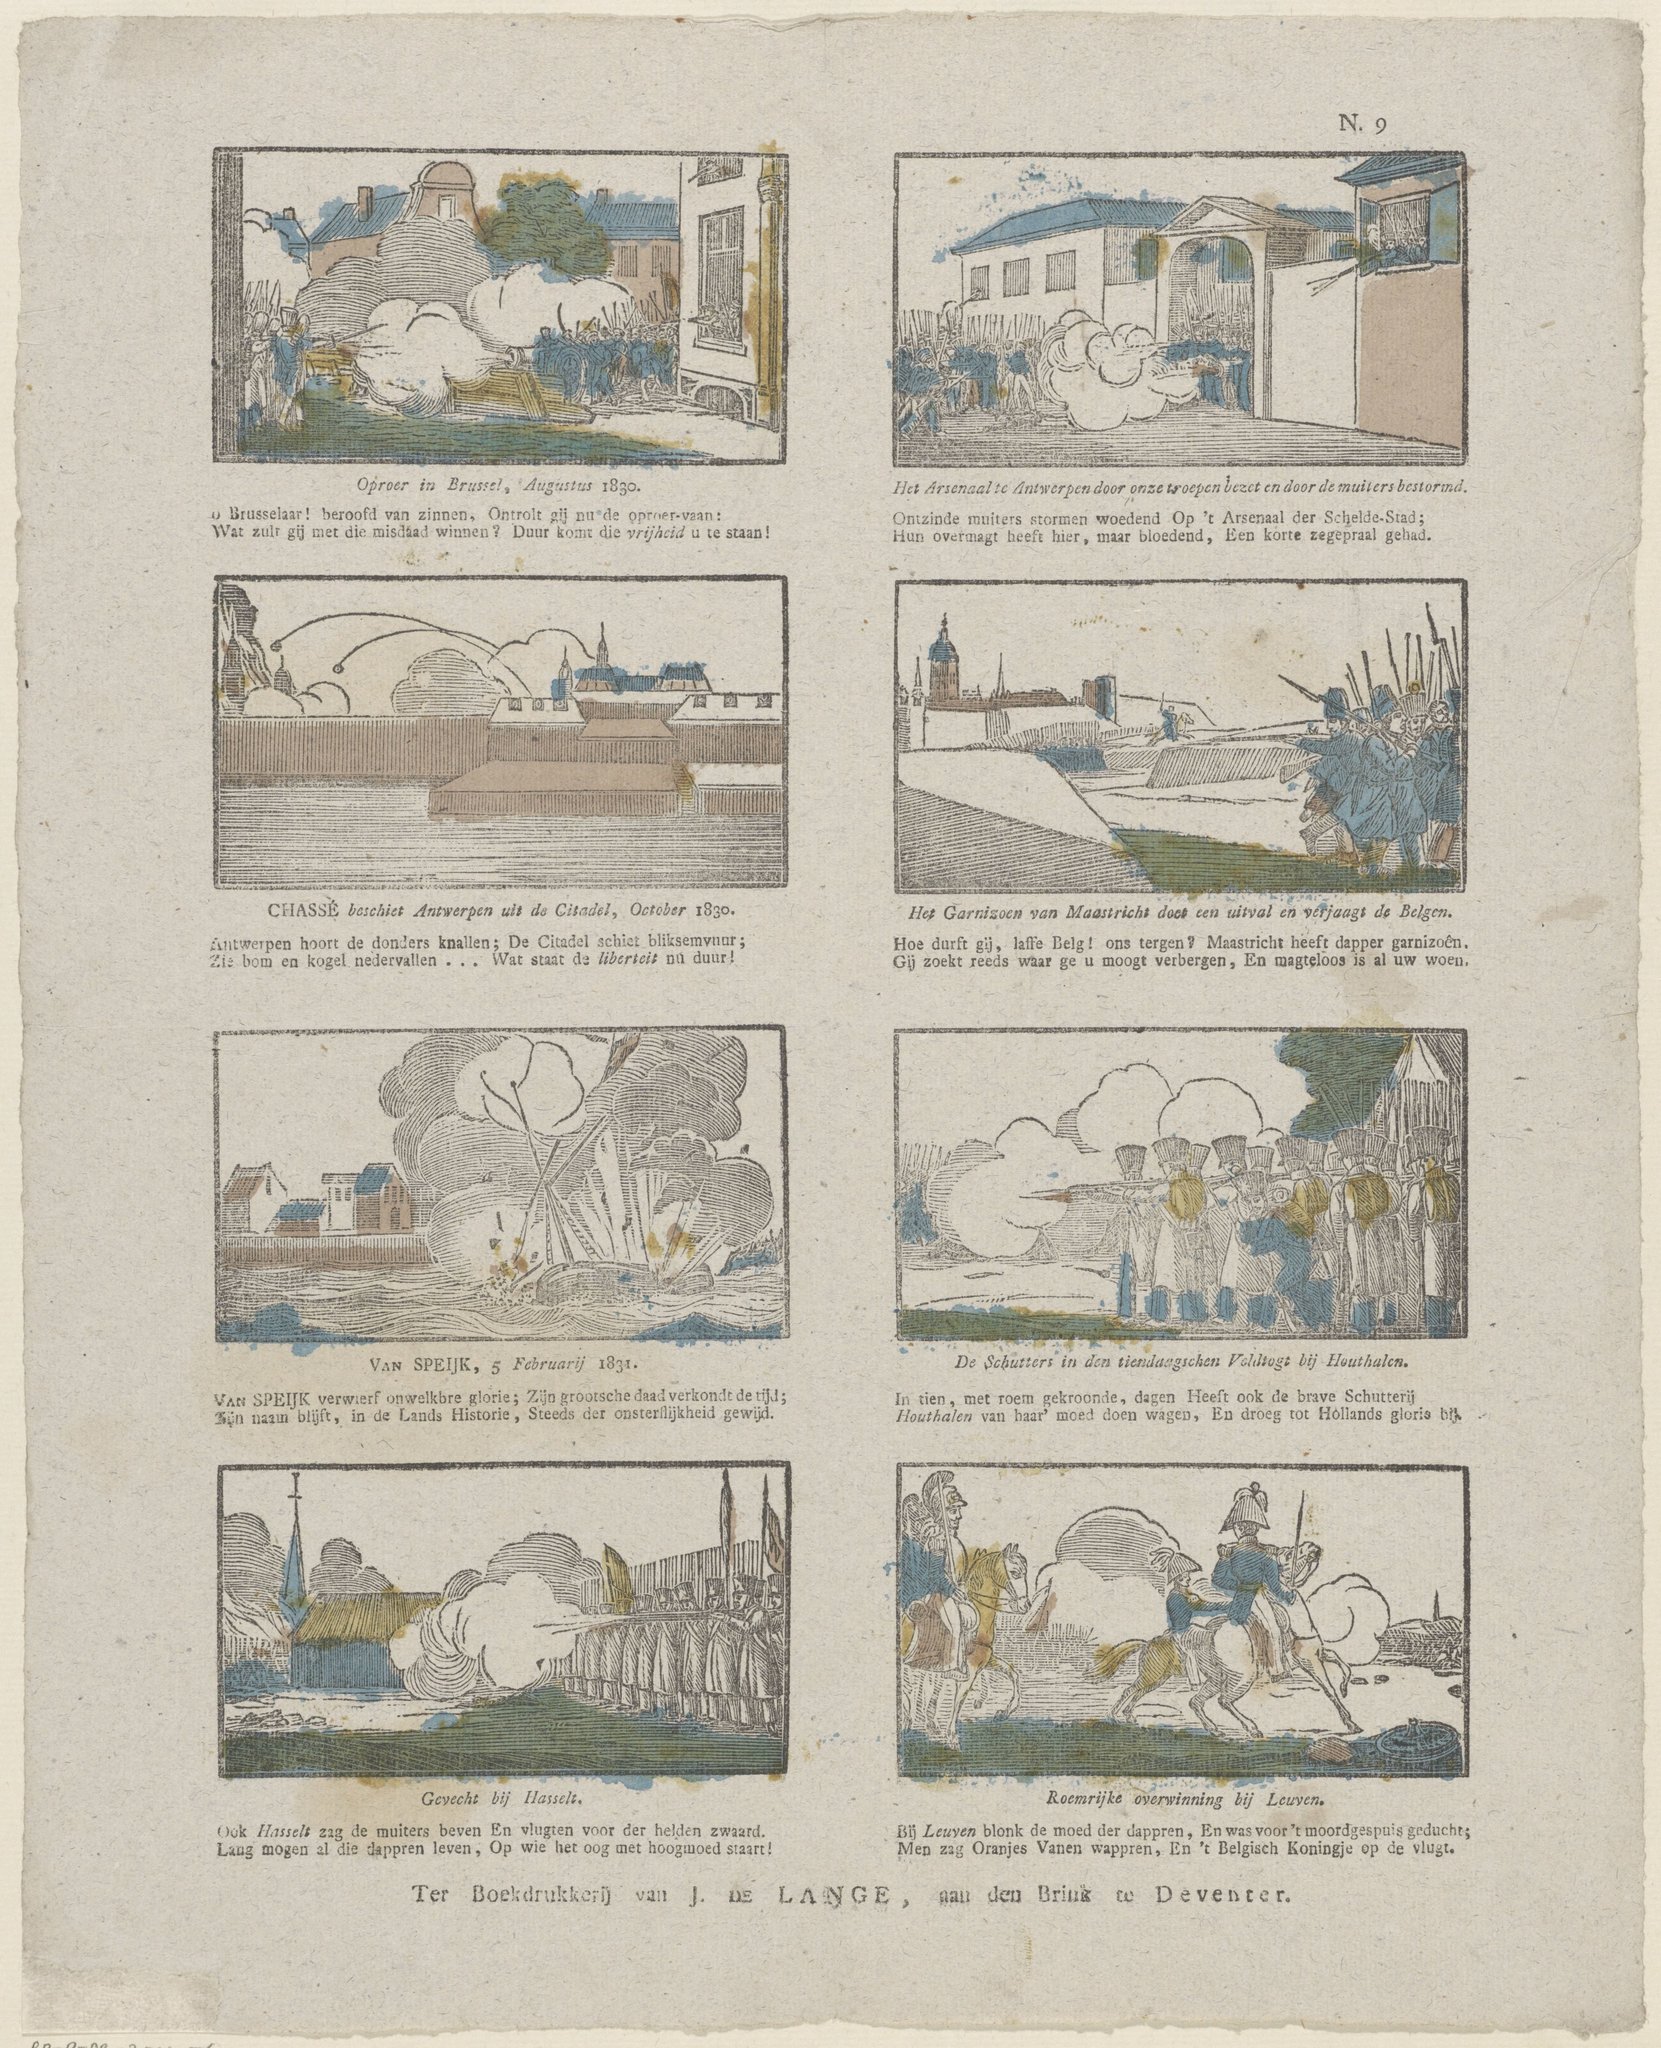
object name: popular print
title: Strijd tegen de Belgen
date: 1822-1849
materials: paper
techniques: colour, letterpress printing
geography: netherlands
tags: amsterdam, antwerp, jan van speyk, battle, revolution, revolt, tailor, dressmaker, orphans, netherlands, belgium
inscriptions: collector's mark: Lugt 2760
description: Blad met 8 voorstellingen over de strijd tegen de Belgen en de zelfopoffering van J.C.J. van Speyk. Onder elke afbeelding een onderschrift.